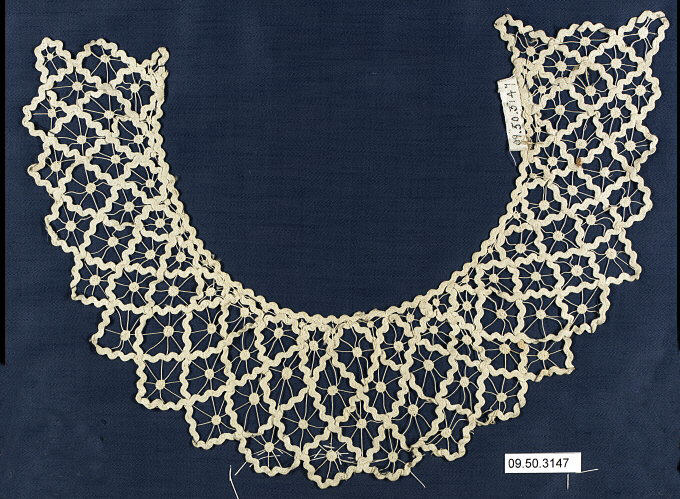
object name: collar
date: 1801-1900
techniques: embroidery